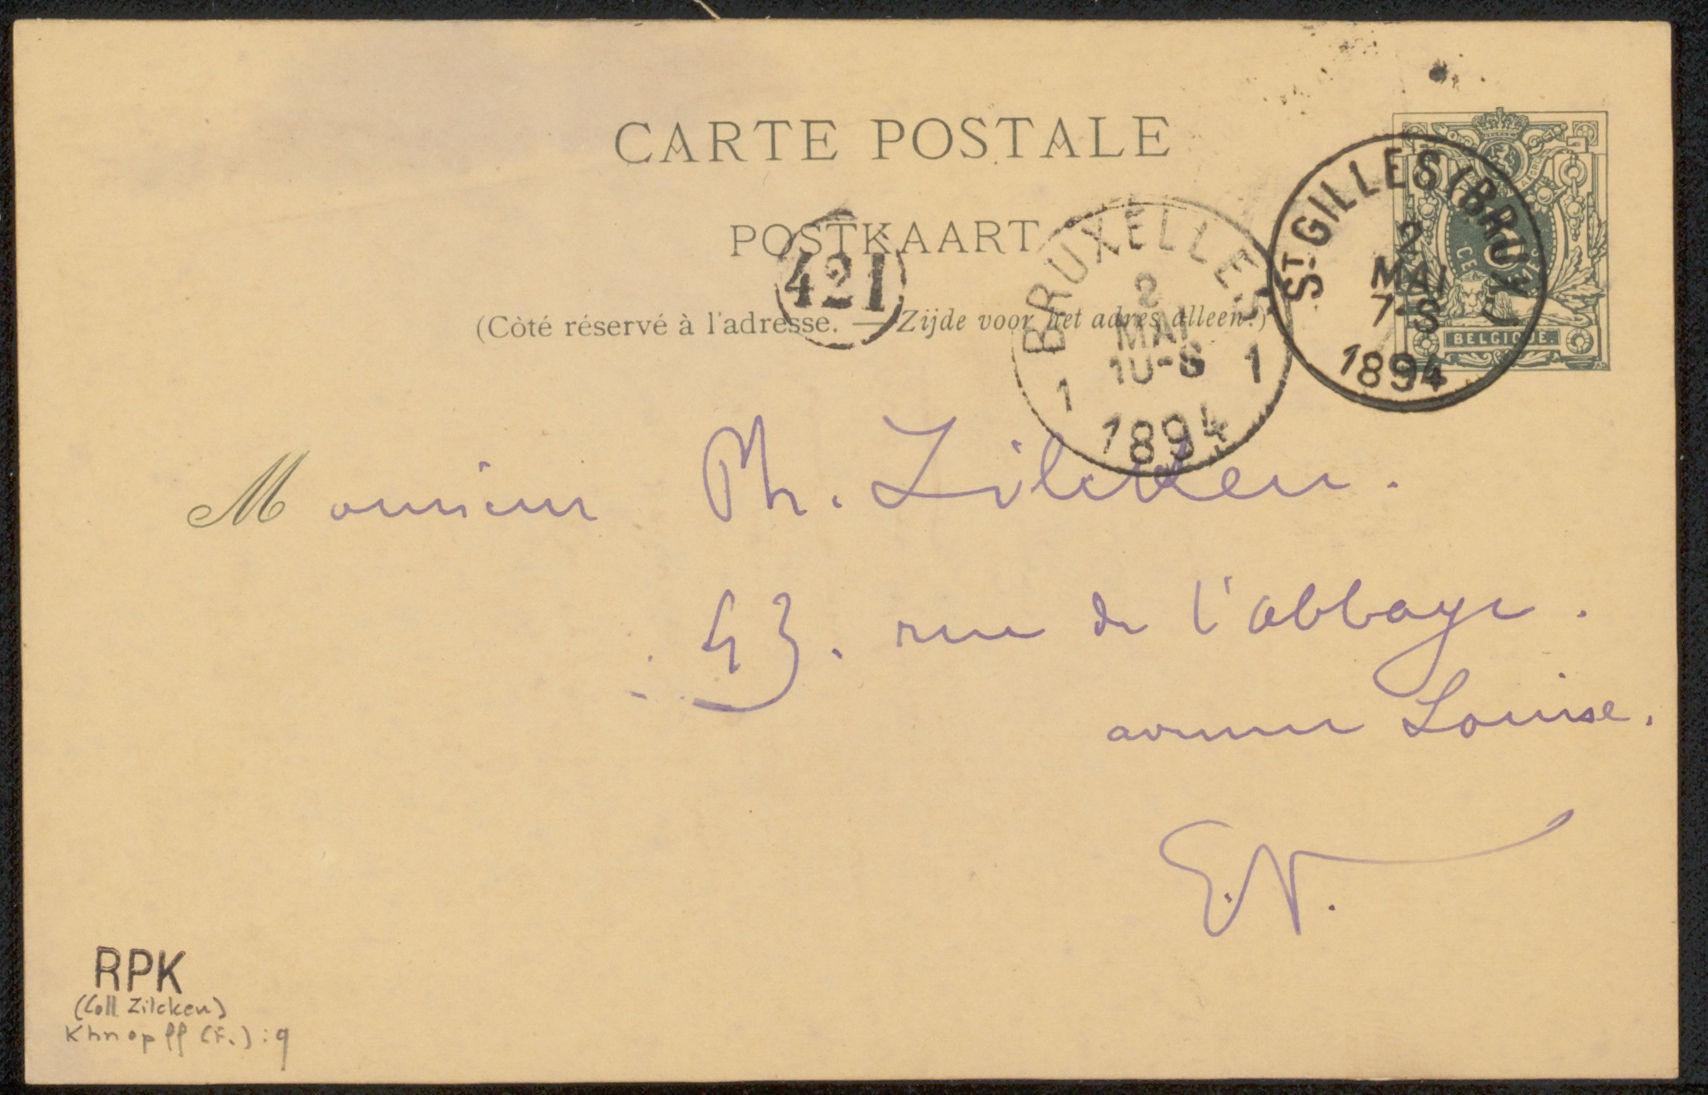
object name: postcard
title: Briefkaart aan Philip Zilcken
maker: fernand khnopff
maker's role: draughtsman, print maker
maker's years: 1858-1921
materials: cardboard, ink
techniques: pen, writing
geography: sint-gillis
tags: the hague, draughtsman, philip zilcken, exhibition ~ art, historical persons (portraits and scenes from the life), antwerp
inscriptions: collector's mark: ‘RPK’